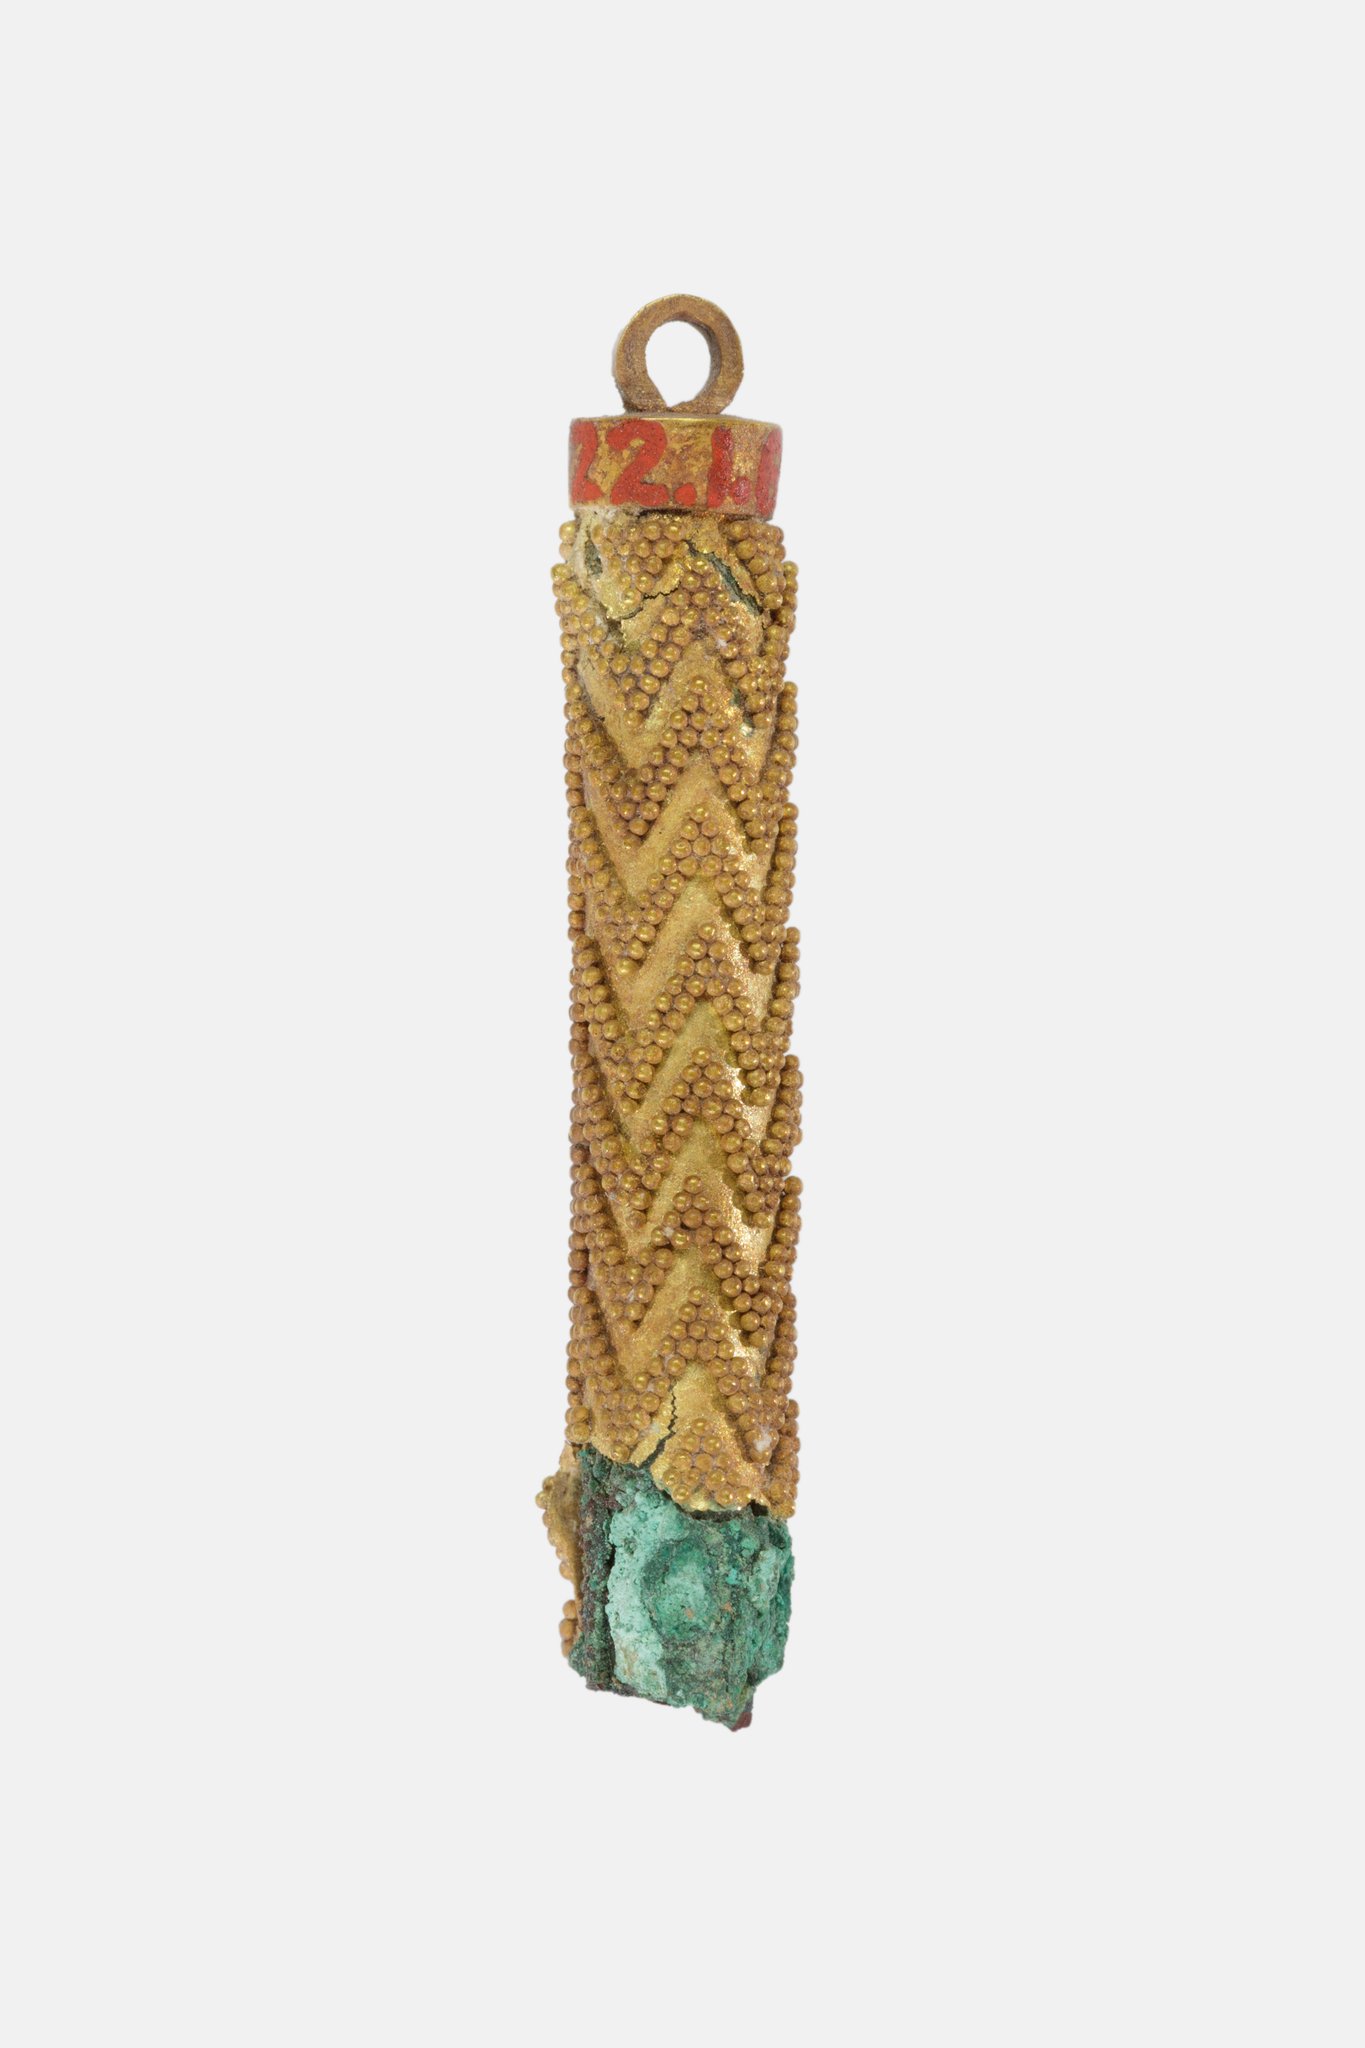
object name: pendant, cylinder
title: Cylindrical pendant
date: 1887-1425 BCE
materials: copper alloy, gold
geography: egypt